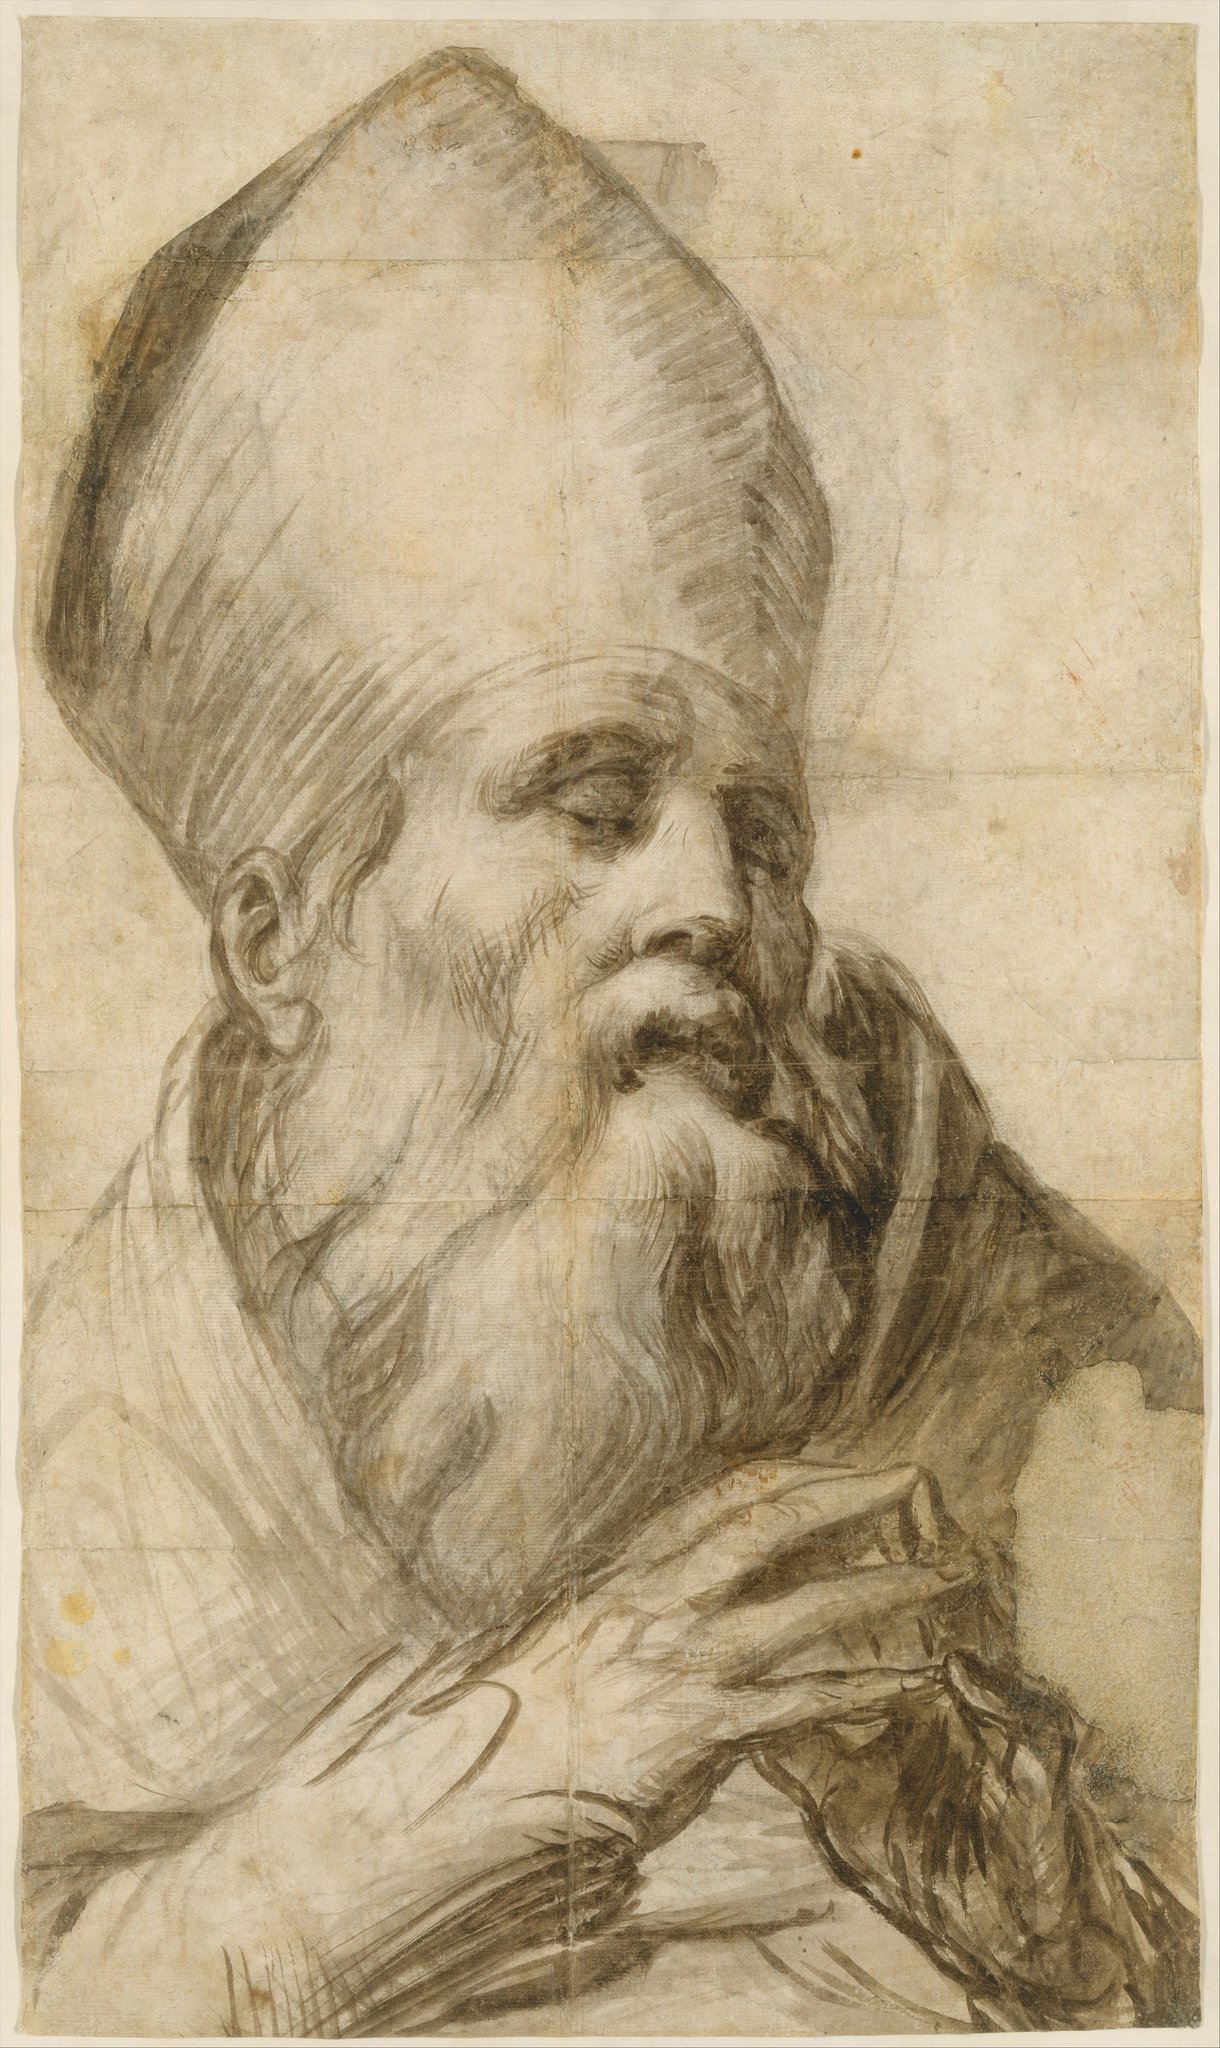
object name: drawing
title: Bishop Saint in Bust-Length (Cartoon for an Altarpiece)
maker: parmigianino (girolamo francesco maria mazzola)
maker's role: artist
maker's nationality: italian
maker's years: 1503-1540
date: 1529-1530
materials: chalk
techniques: brush, wash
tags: men,bishops